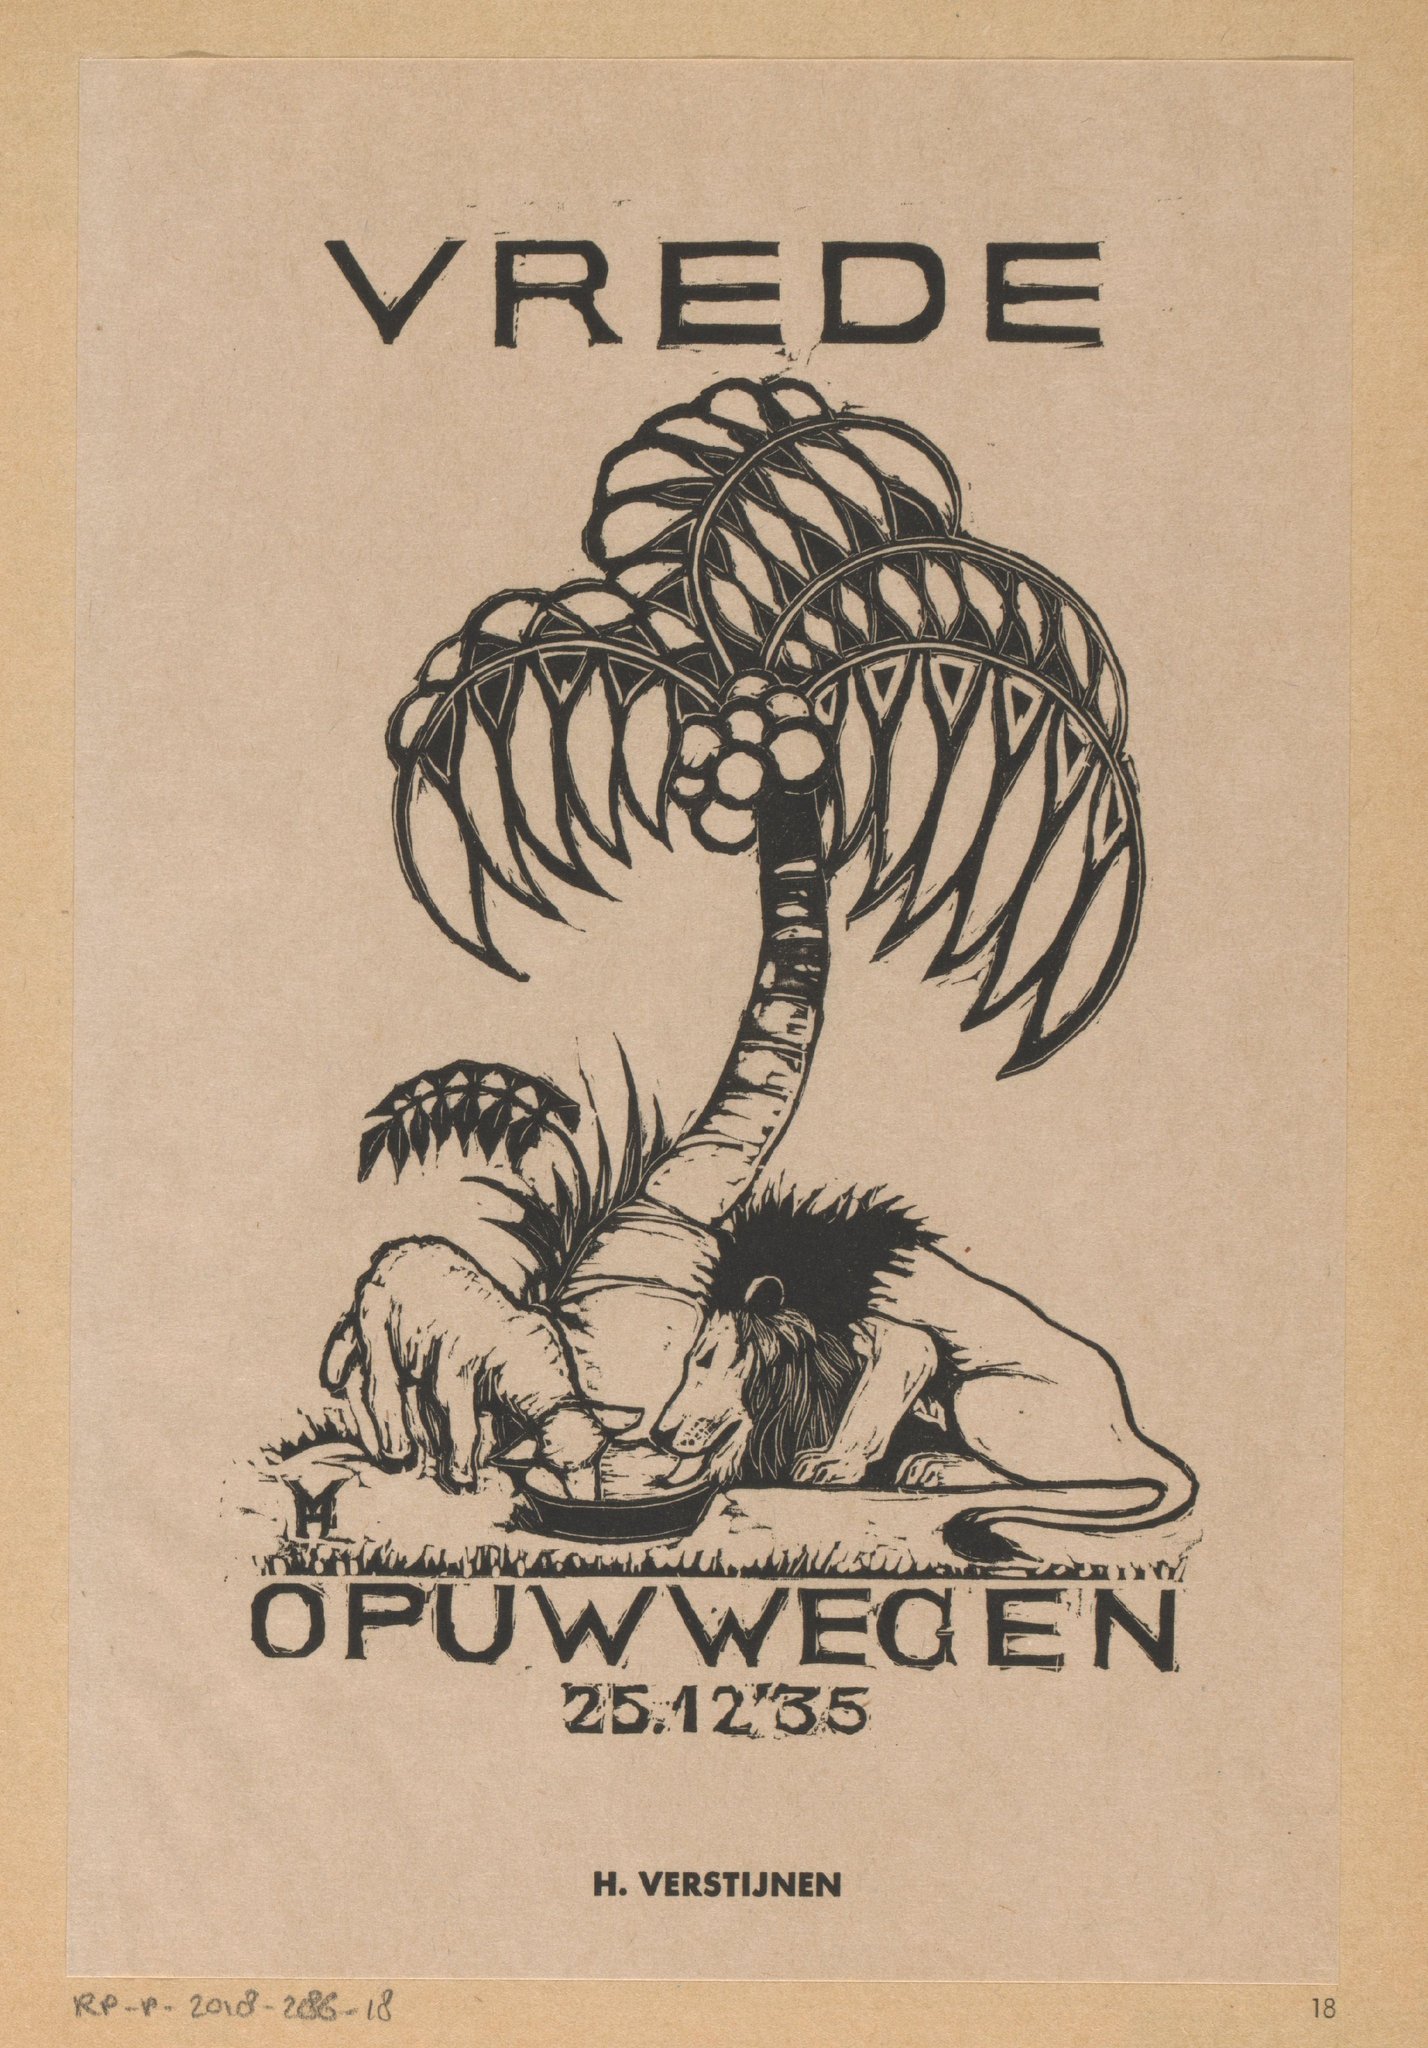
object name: christmas card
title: Kerstkaart van Henri Verstijnen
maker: henri verstijnen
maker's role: draughtsman, print maker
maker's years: 1882-1940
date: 1912-1935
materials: paper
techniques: woodcut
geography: netherlands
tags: henri verstijnen, lamb, trees: palm-tree, beasts of prey, predatory animals: lion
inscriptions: date